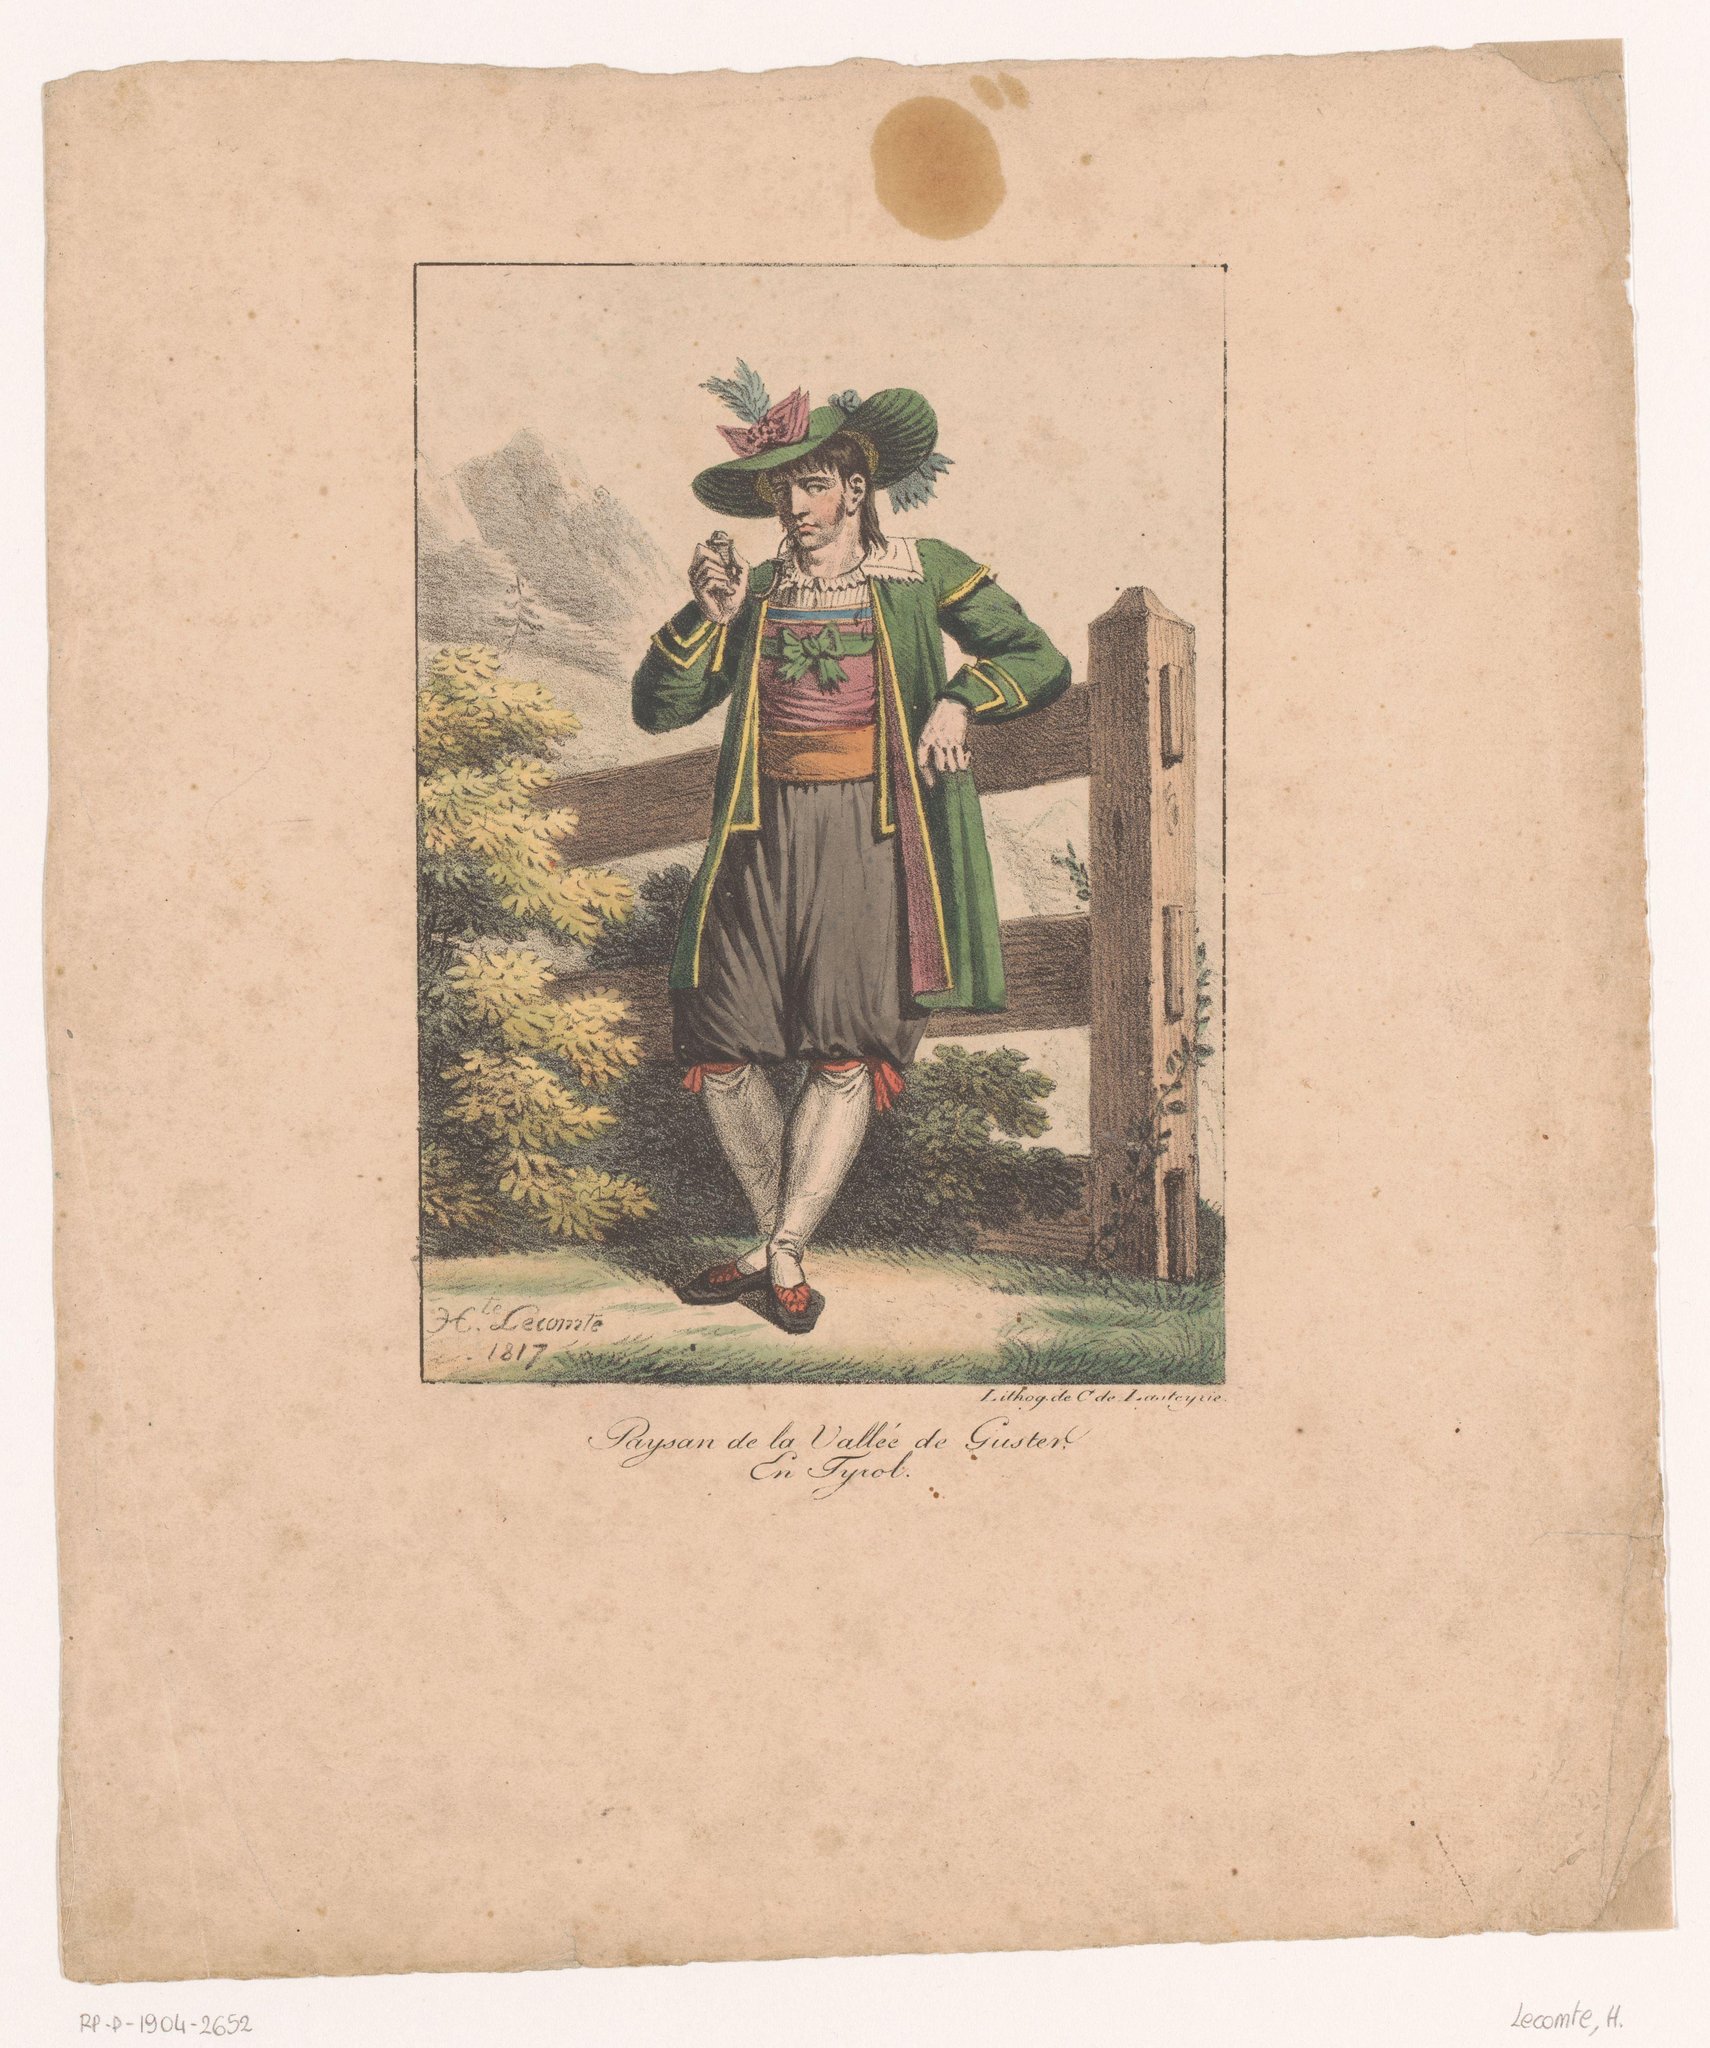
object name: print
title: Europeanen in regionale kostuums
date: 1817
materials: paper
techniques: hand coloring, lithograph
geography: paris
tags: farmers, folk costume, regional costume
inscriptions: collector's mark: Lugt 2228a